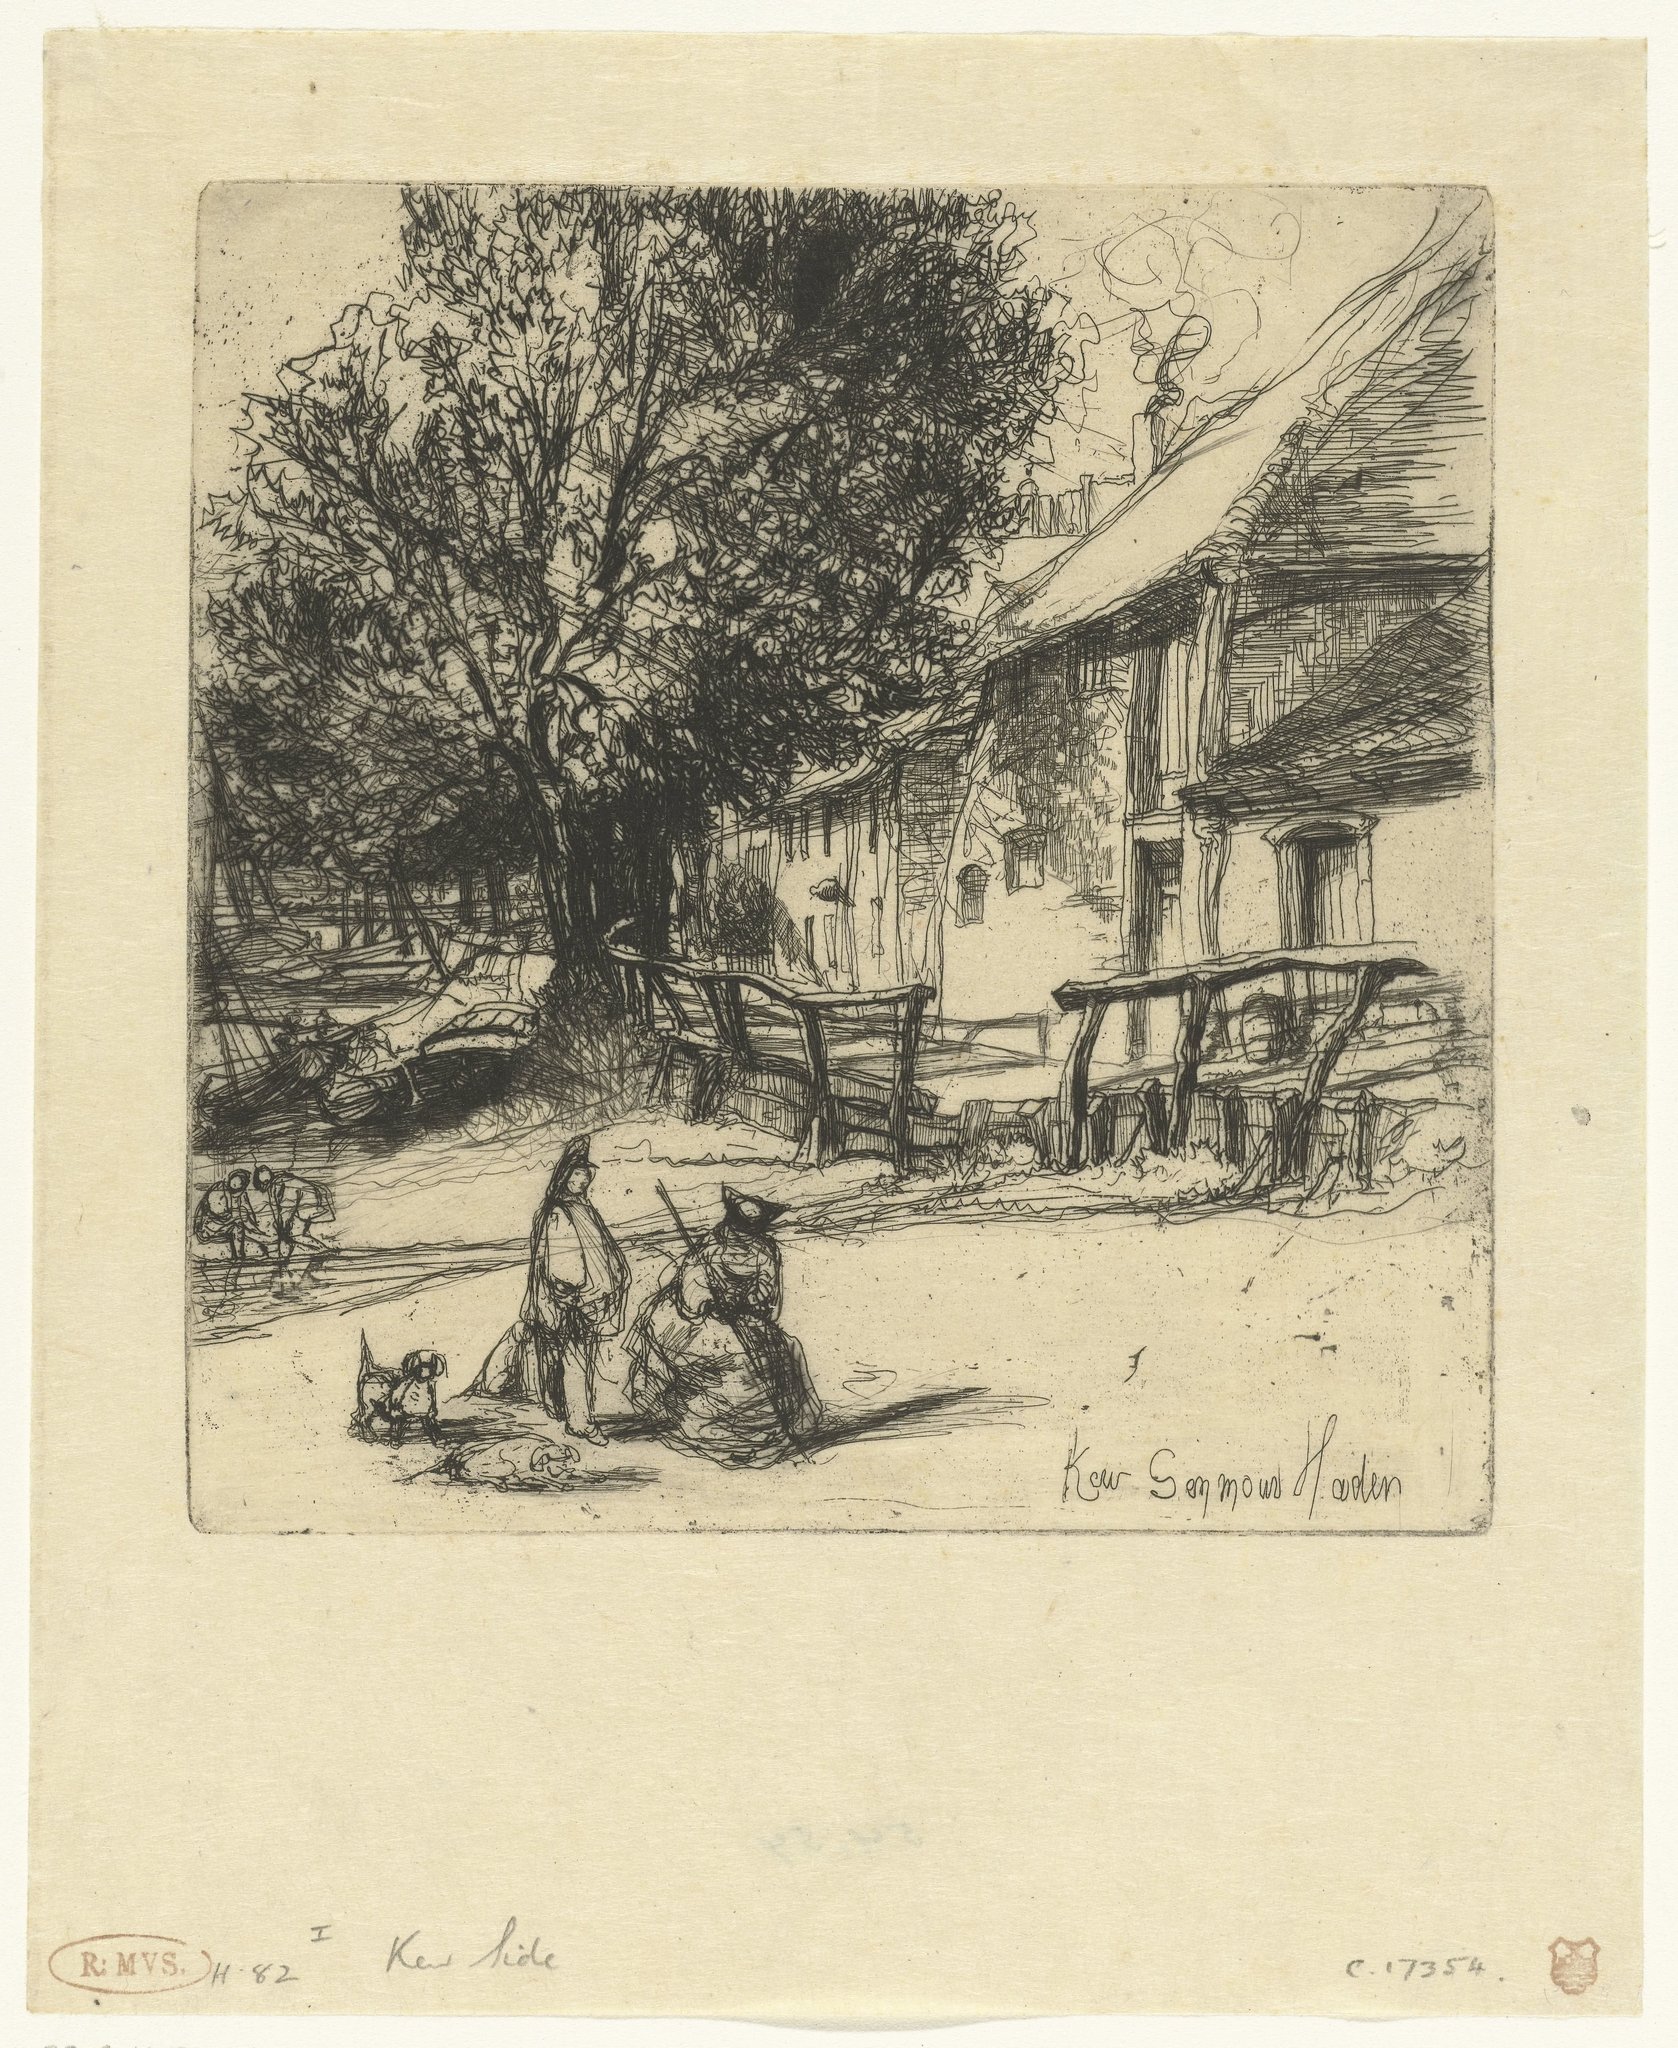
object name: print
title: Kew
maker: francis seymour-haden (sir)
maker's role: print maker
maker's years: 1818-1910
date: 1864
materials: paper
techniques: etching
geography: england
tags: village, thames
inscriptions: collector's mark: Lugt 2228, collector's mark: Lugt 2760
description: Een rij huizen langs het water. Op de oever een aantal personen, waaronder een man en een vrouw met twee honden.